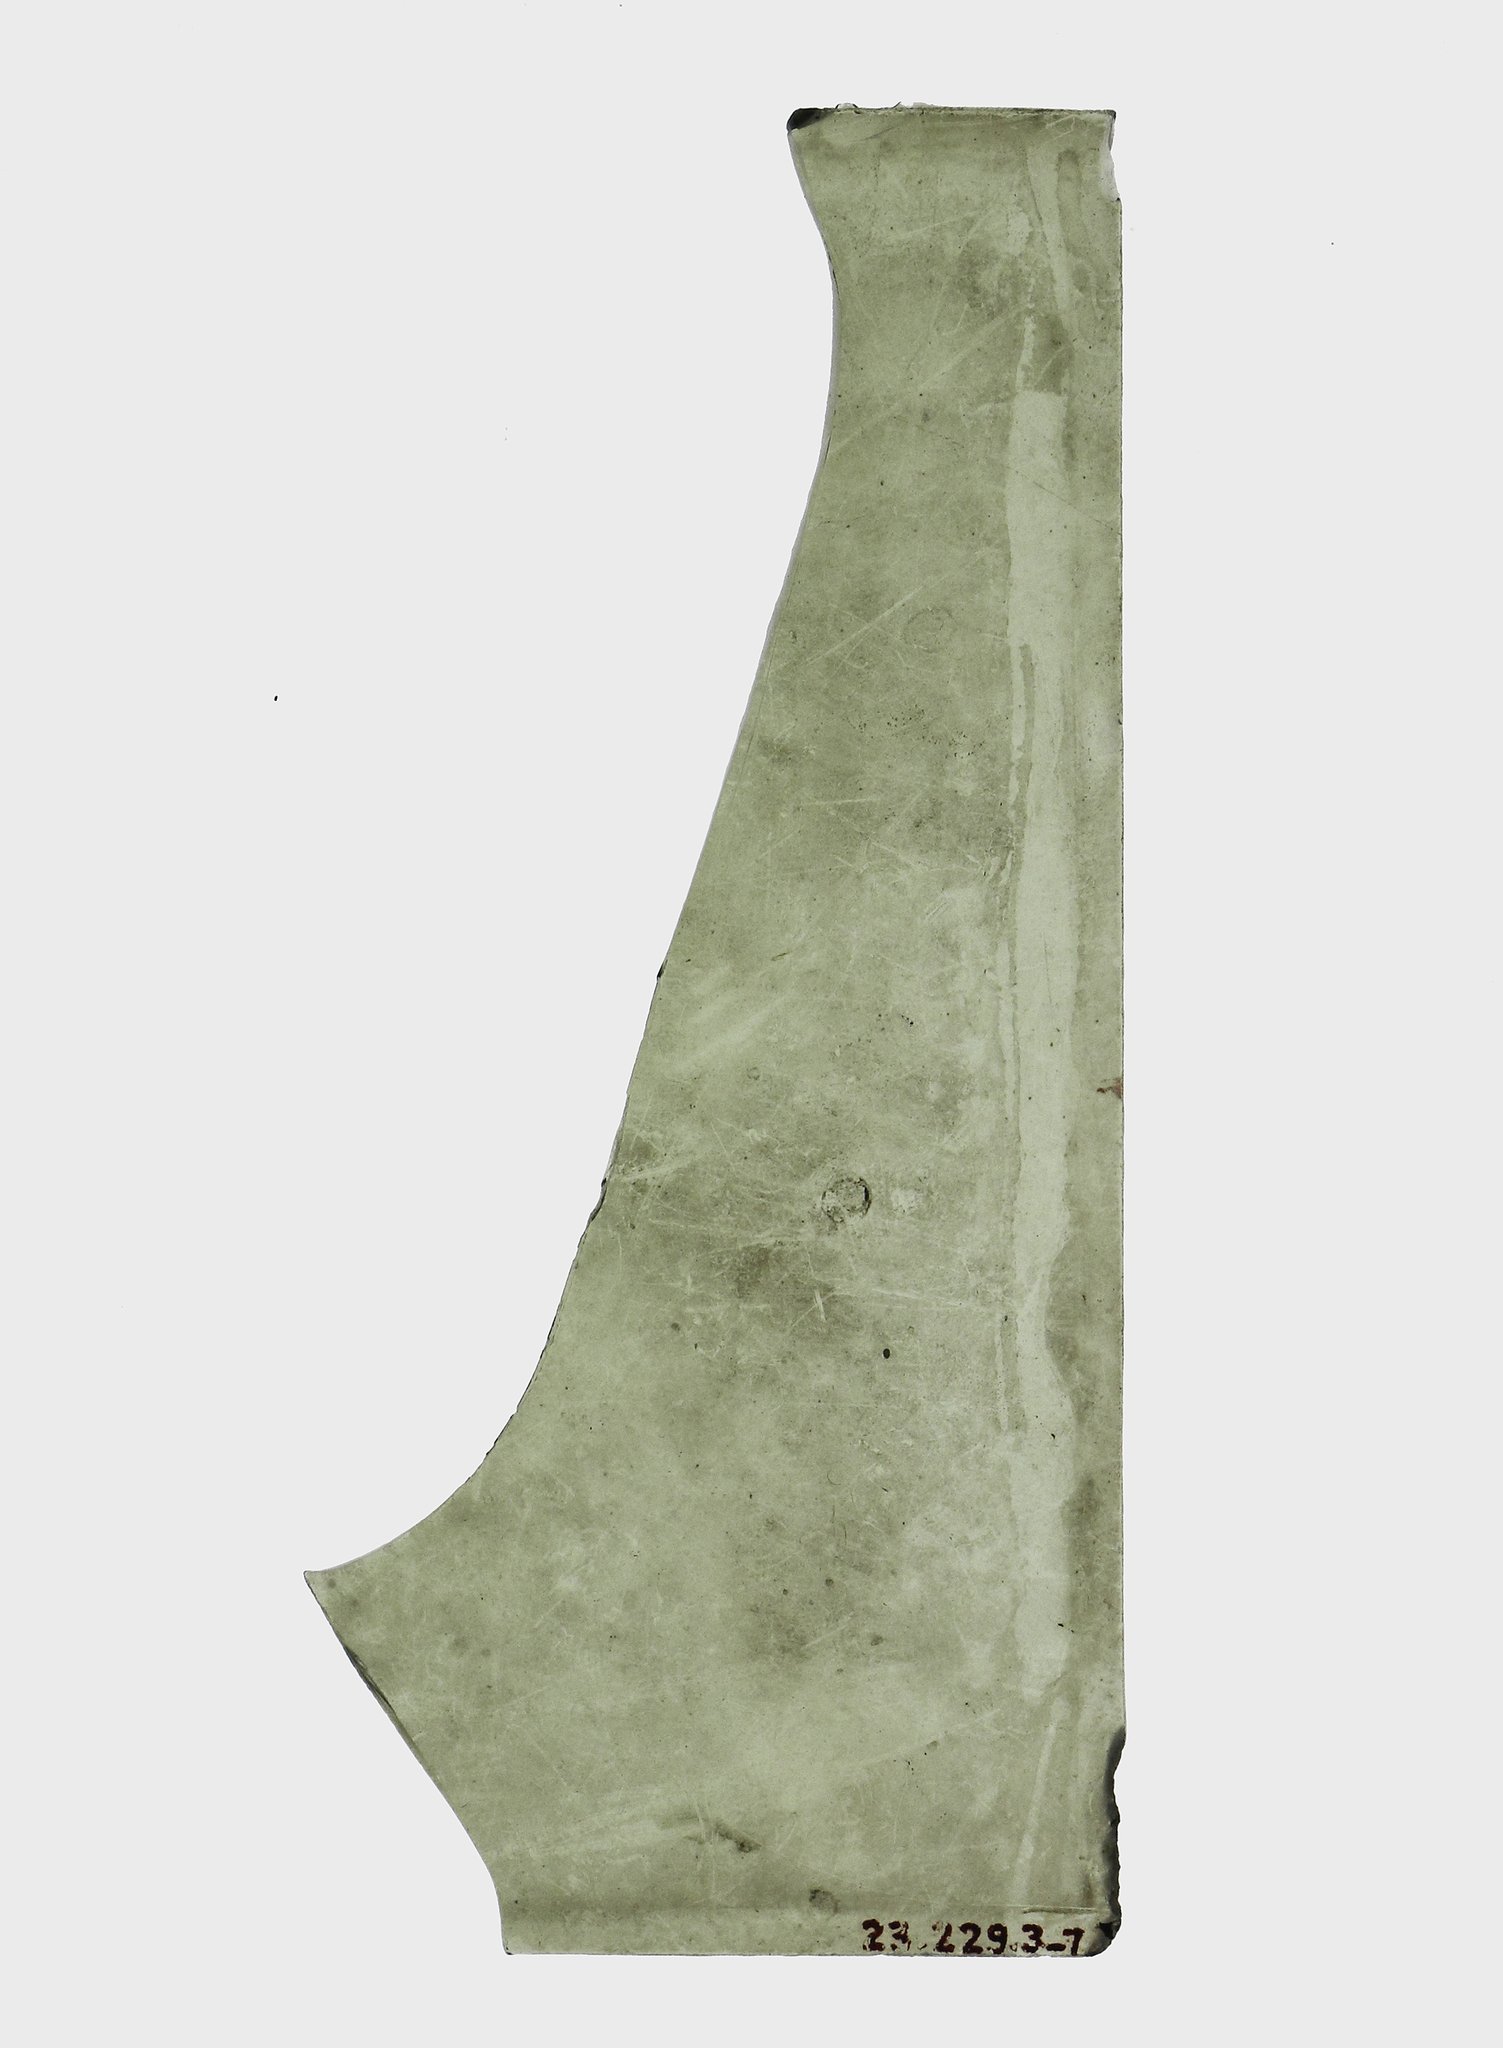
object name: fragment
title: Glass Fragment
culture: french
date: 1775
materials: glass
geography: france